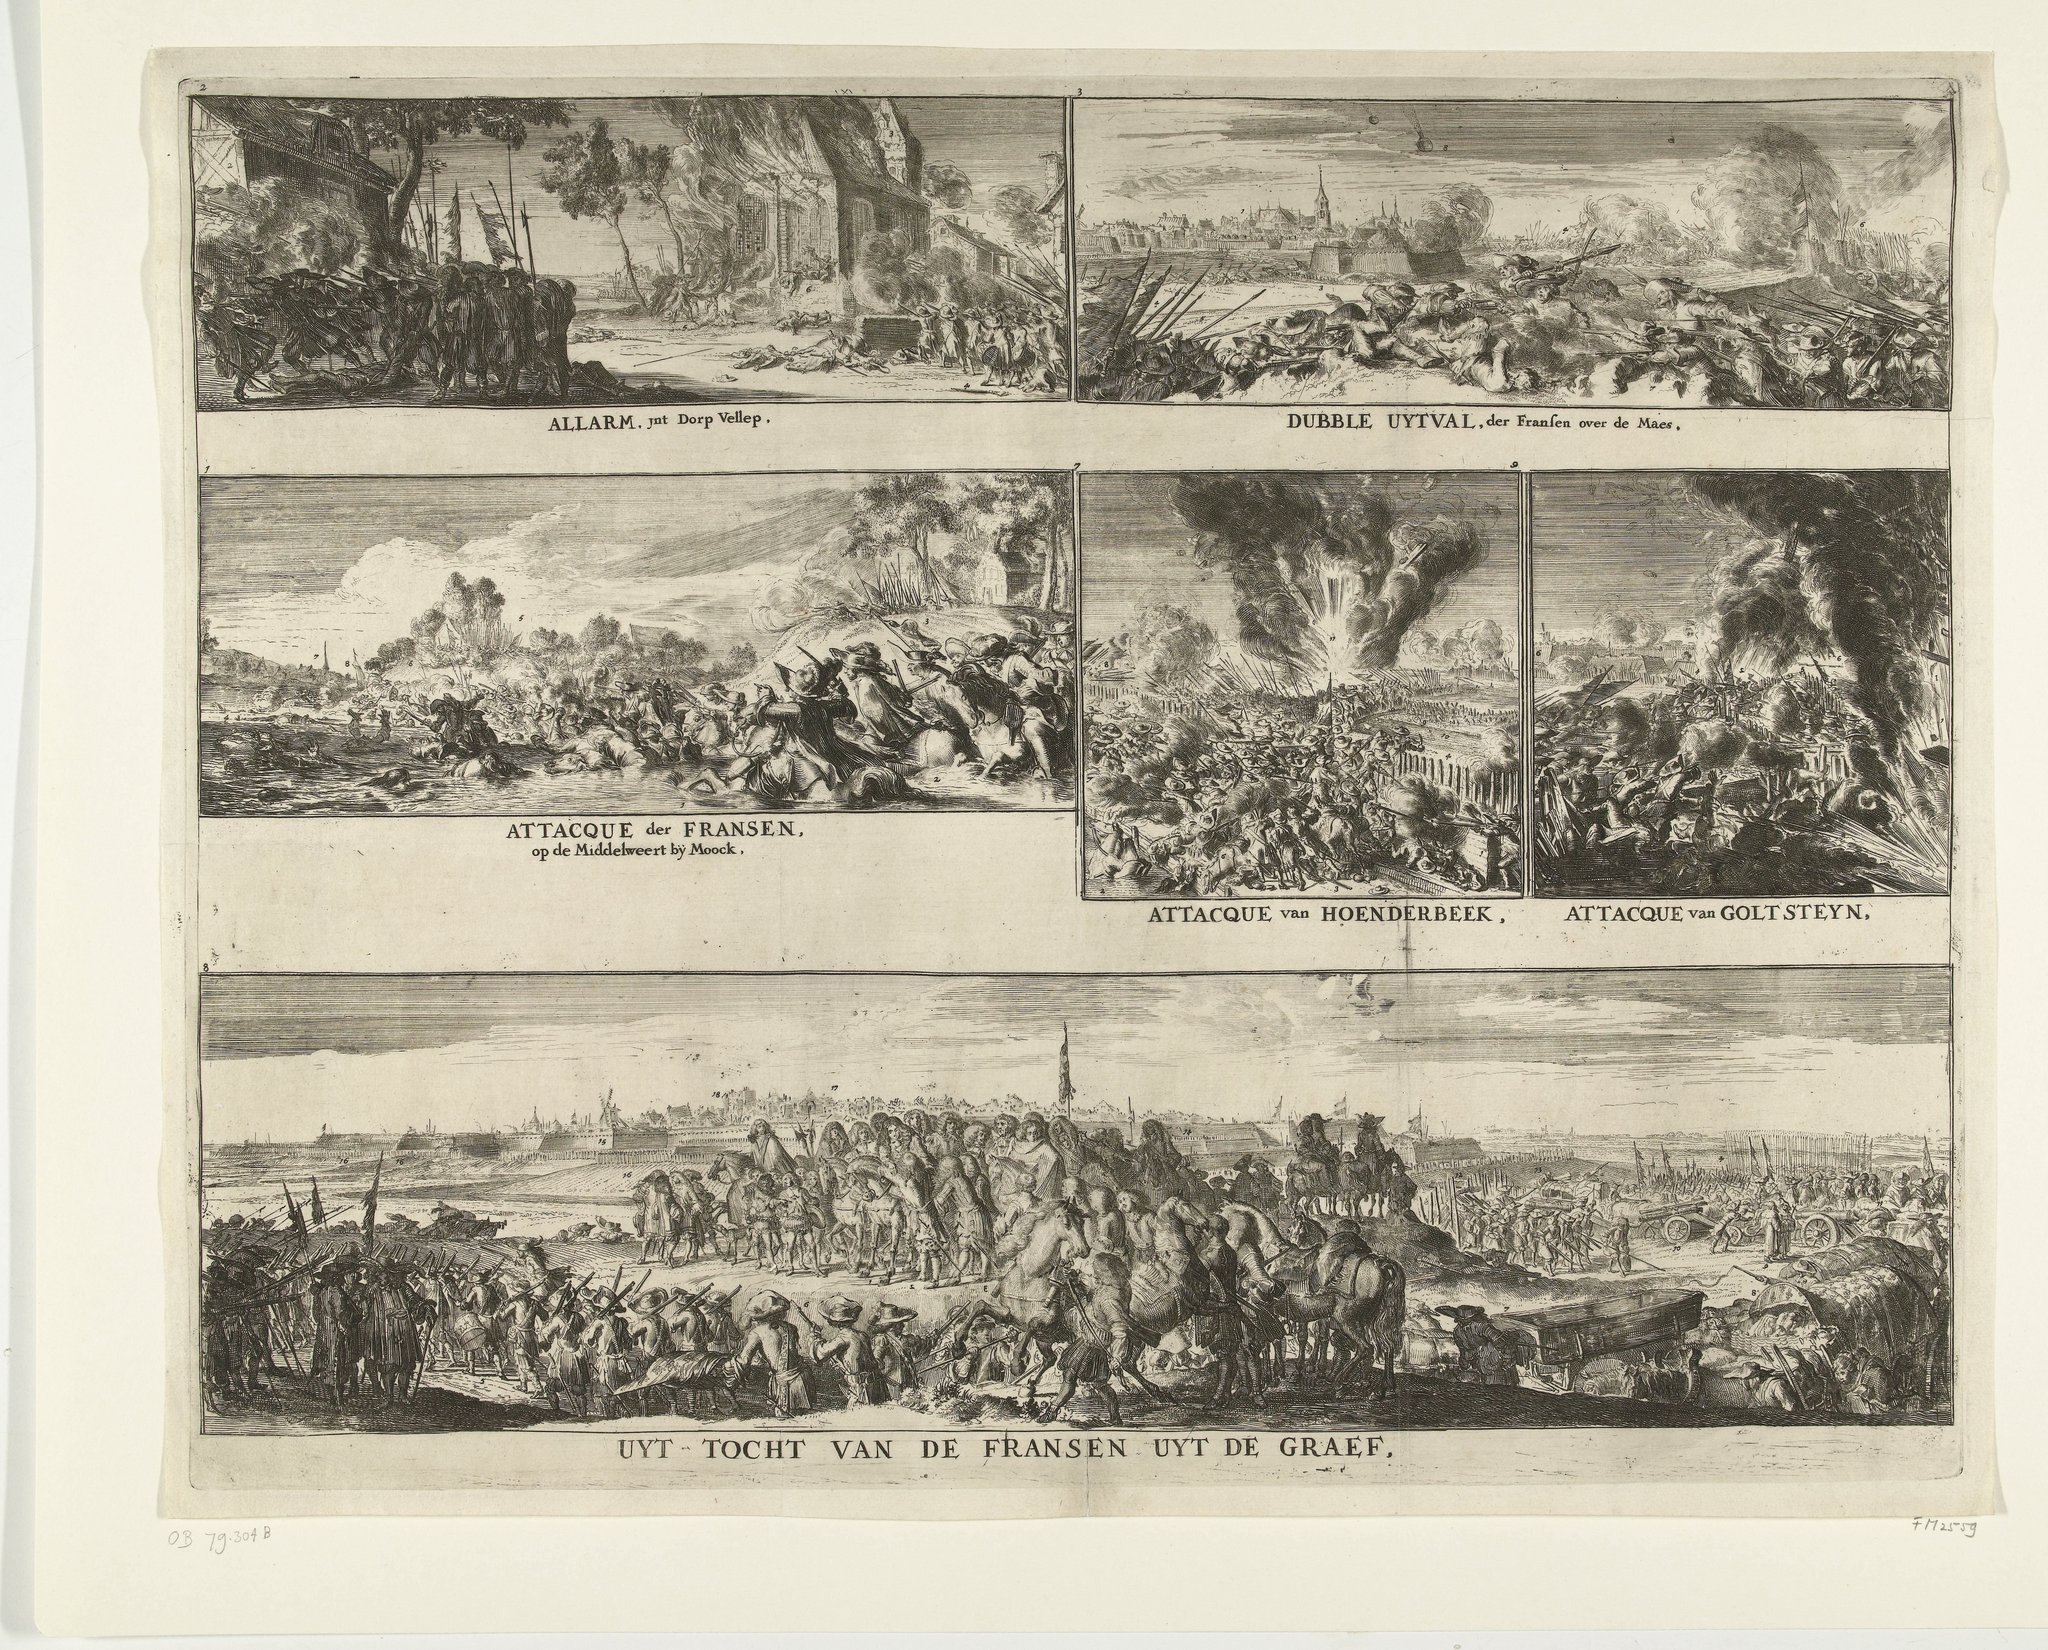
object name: print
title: Zes scènes uit het beleg en de verovering van Grave door Willem III, 1674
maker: romeyn de hooghe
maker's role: draughtsman, goldsmith, painter, print maker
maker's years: 1645-1708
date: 1674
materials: paper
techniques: engraving, etching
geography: amsterdam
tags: the hague, william iii (prince of orange and king of england, scotland, and ireland), siege, position war, battle, fighting in general, grave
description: Zes scènes uit het beleg en de verovering van Grave door Willem III, 1674, 25 juli tot 29 oktober 1674. Scènes genummerd 1, 2, 3, 7 en 8. Onderdeel van de uitvoerige voorstelling en beschrijving van deze gebeurtenissen in 2 bladen met 1 grote voorstelling en 6 kleinere voorstellingen. Hierbij ook enkele tekstbladen.